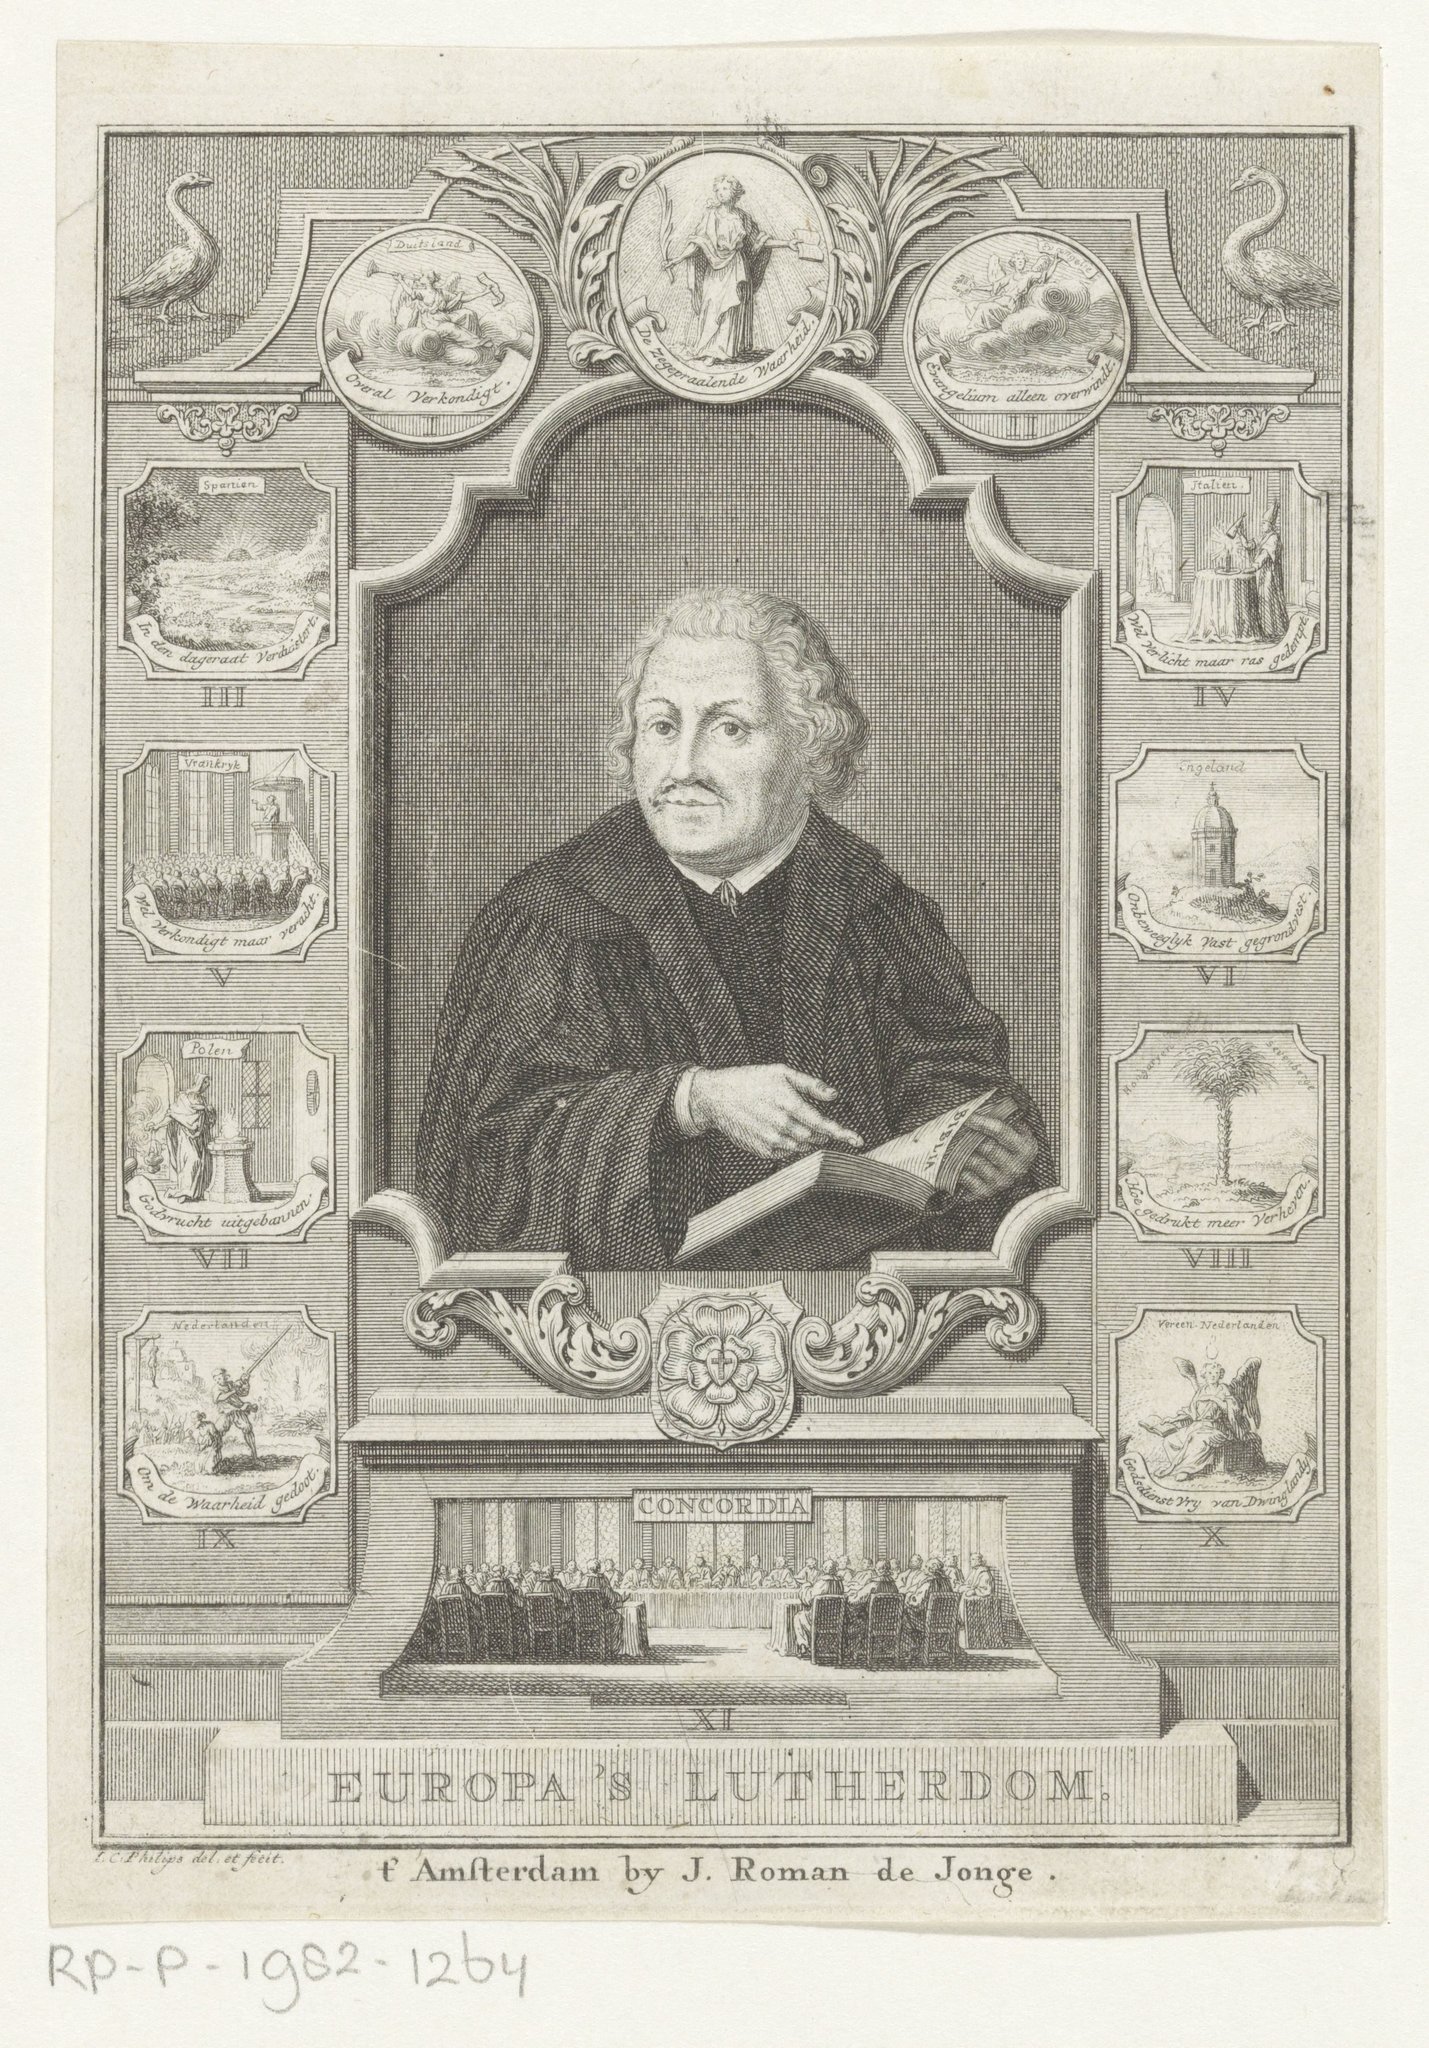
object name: print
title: Portret van Martin Luther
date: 1745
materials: paper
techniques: engraving, etching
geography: amsterdam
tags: priest, martin luther, protestant churches and denominations, theologian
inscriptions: collector's mark: Lugt 2760, collector's mark: Lugt 2228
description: Portret van Martin Luther met een opengeslagen bijbel in de hand. Rondom in de omlijsting twaalf medaillons met allegorieën op de verspreiding van zijn ideeën, het lutheranisme, in Europa.